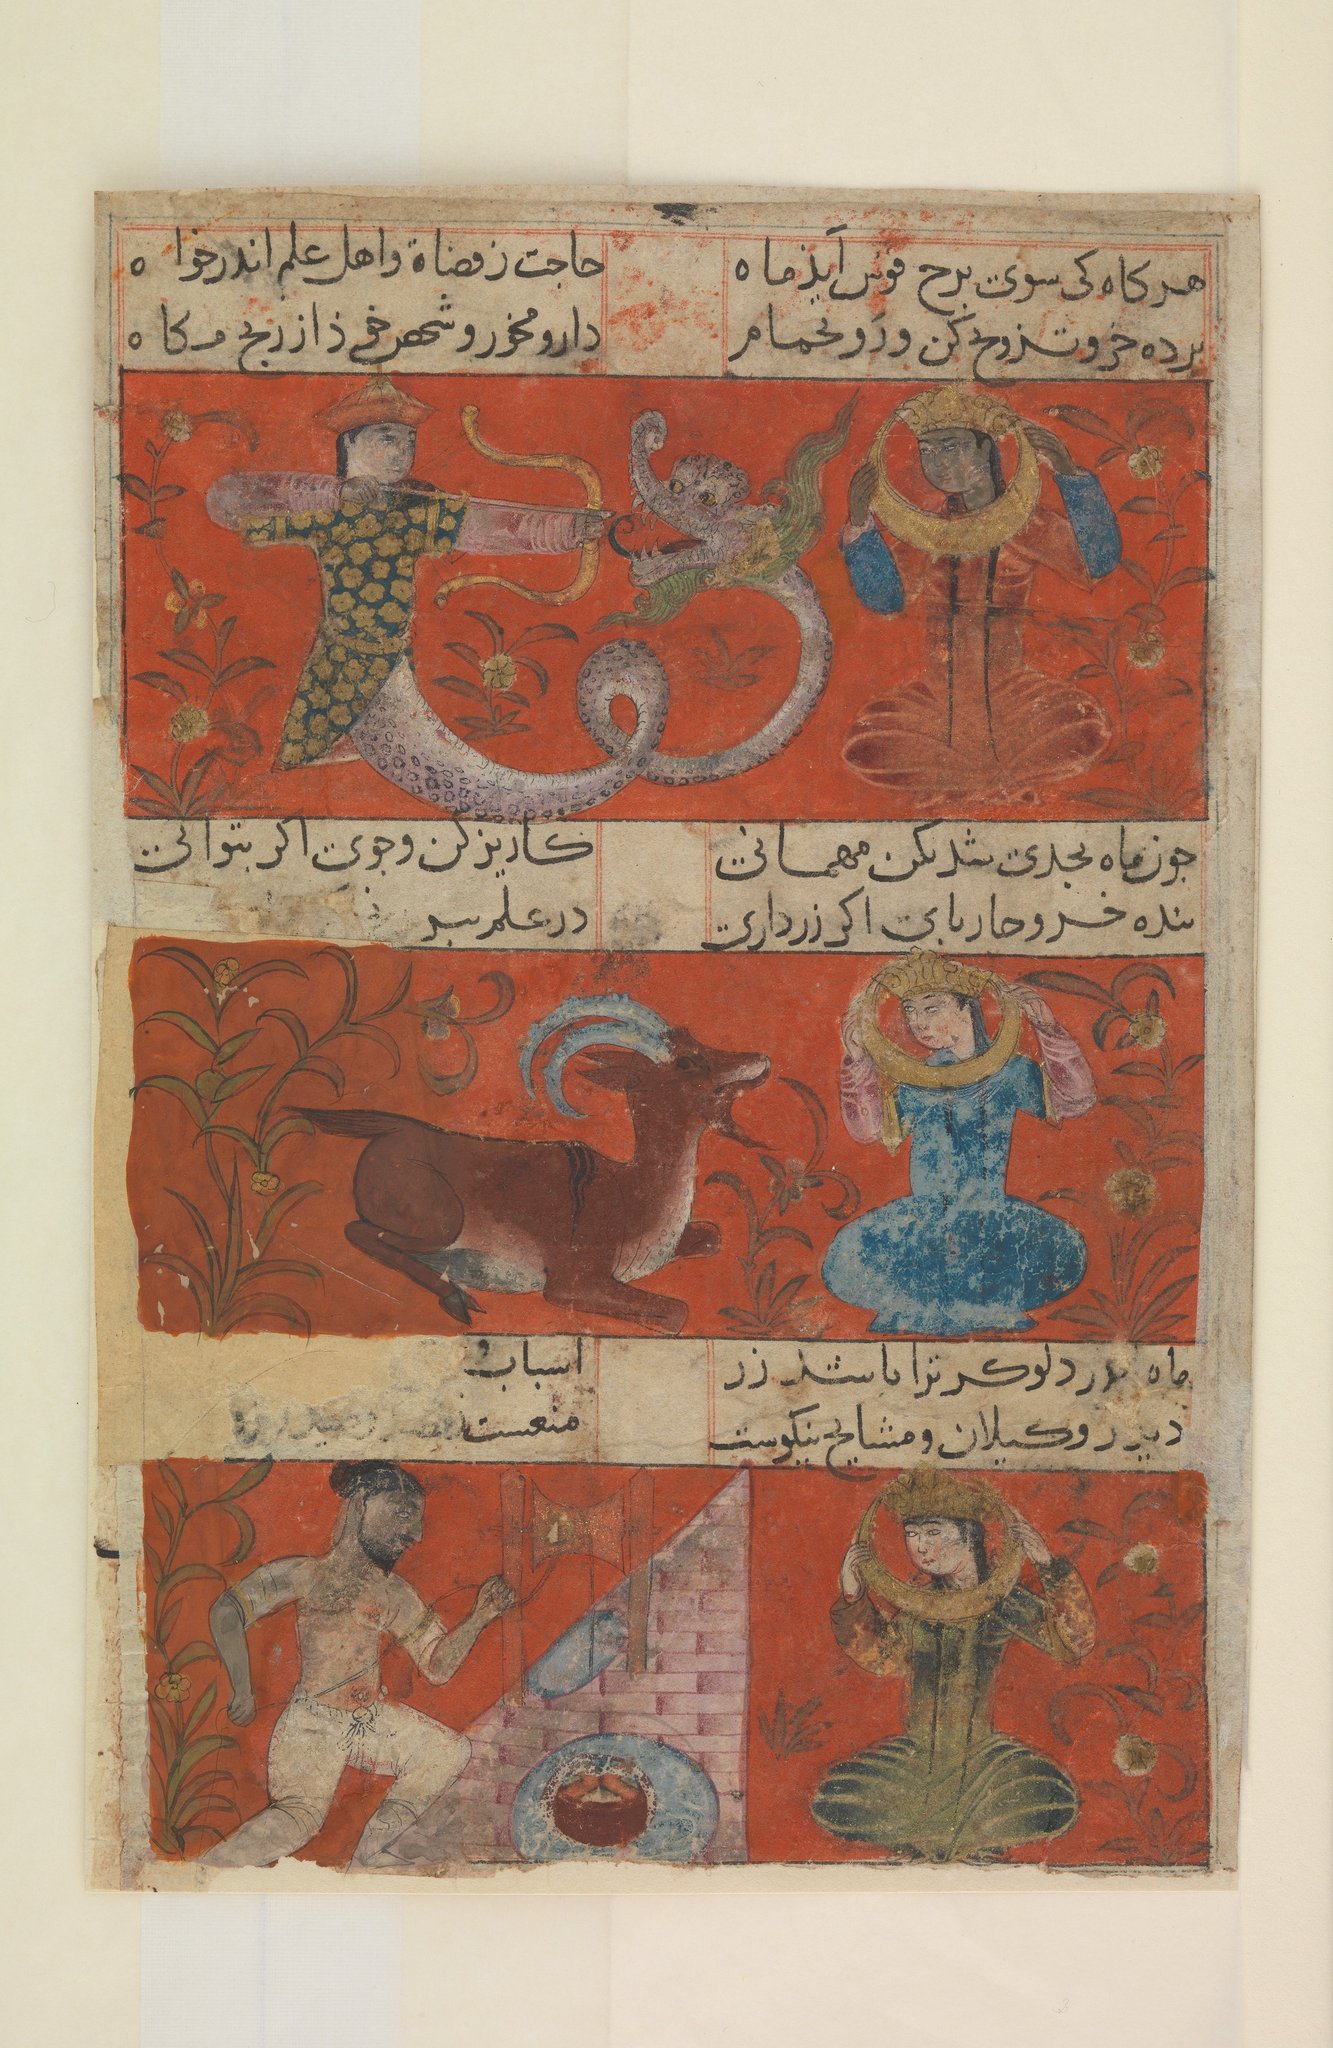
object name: folio from an illustrated manuscript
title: Folio from a Mu'nis al-ahrar fi daqa'iq al-ash'ar (The Free Man's Companion to the Subtleties of Poems) of Jajarmi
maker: muhammad ibn badr al-din jajarmi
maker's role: author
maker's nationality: iranian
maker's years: 1315-1365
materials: gold, ink, paper, watercolor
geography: iran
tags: poetry,wells,goats,moon,zodiac